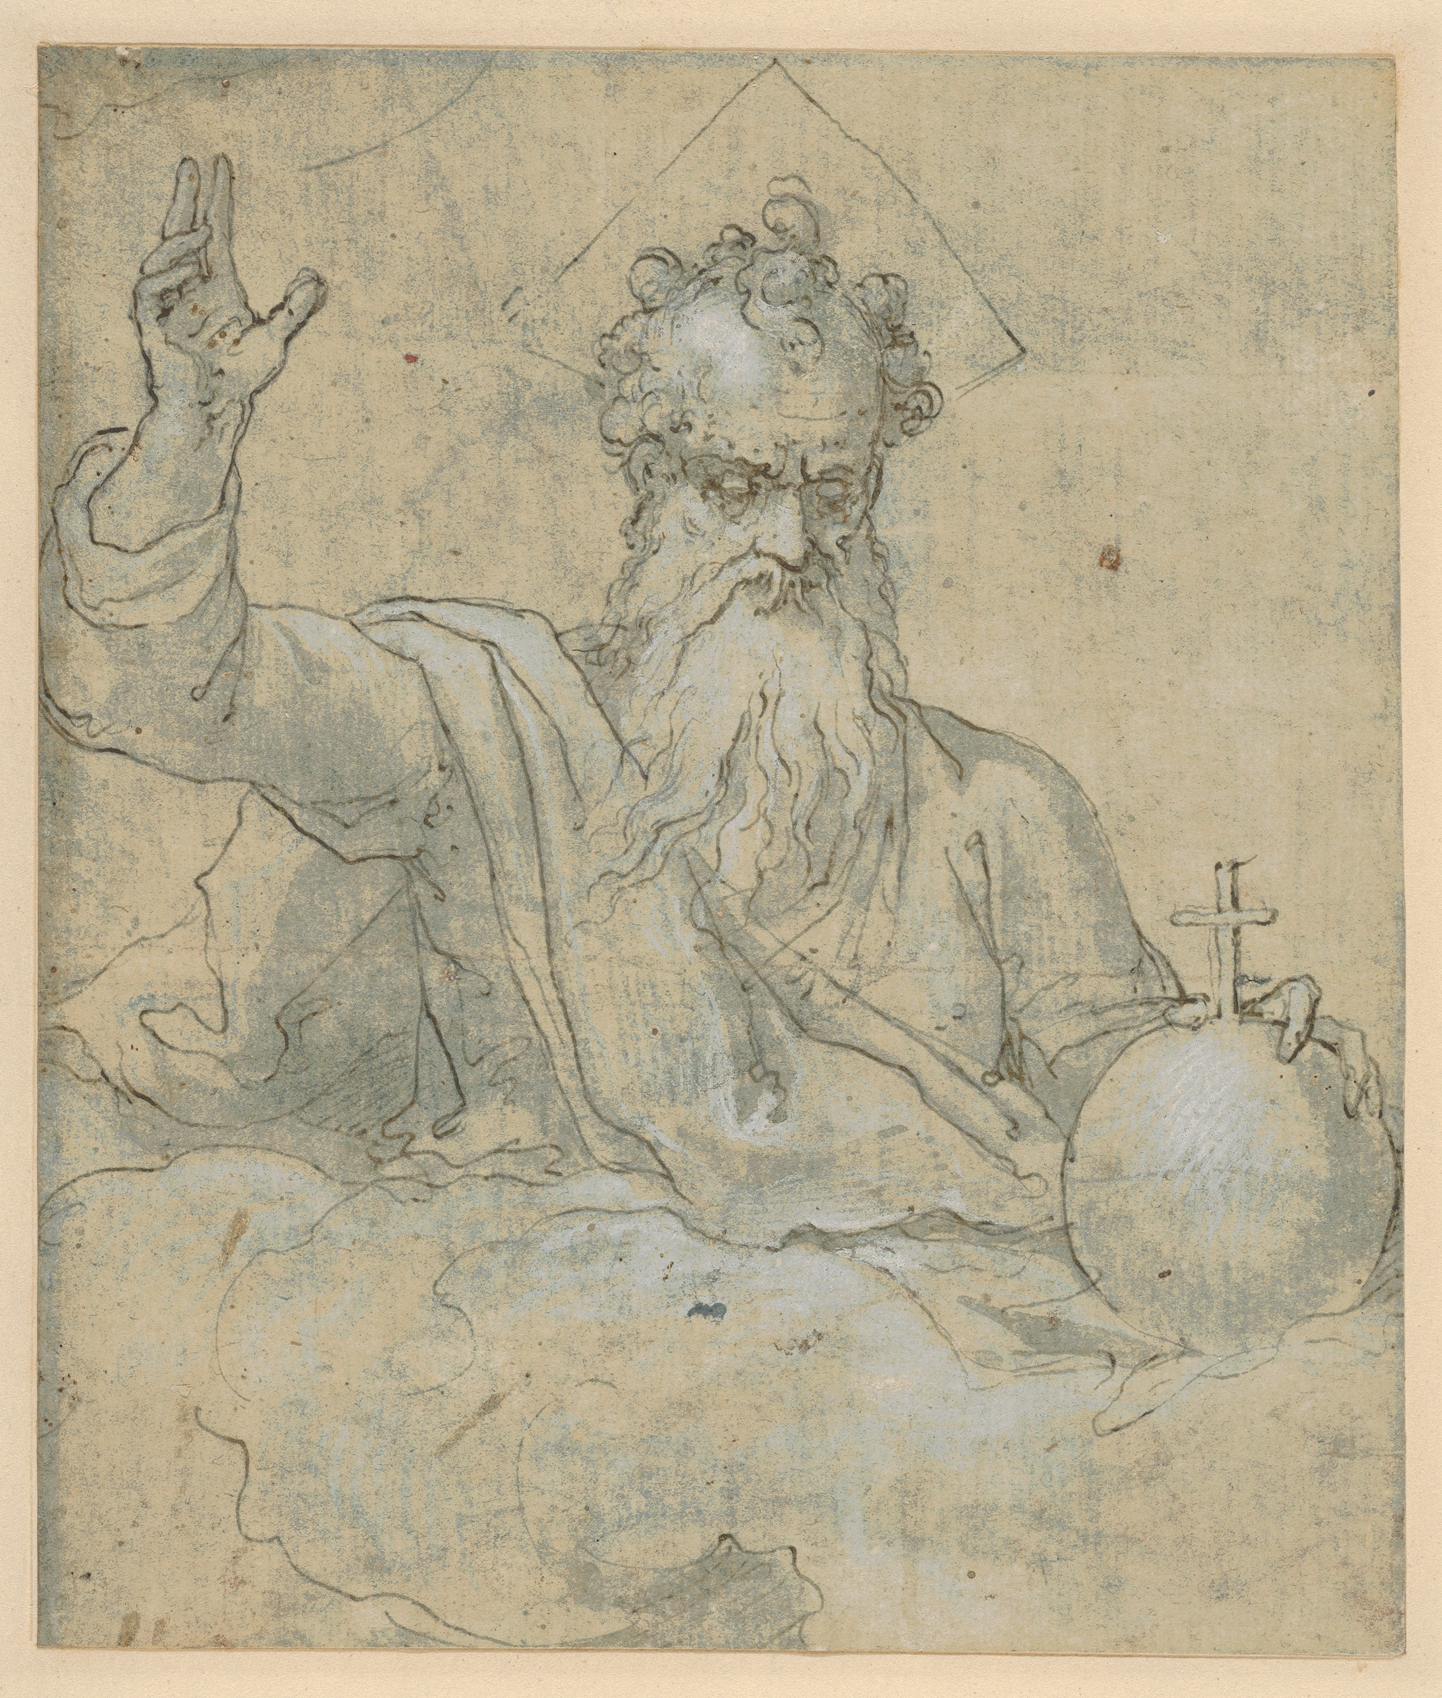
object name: drawing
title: God the Father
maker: federico zuccaro (zuccari)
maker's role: artist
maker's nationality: italian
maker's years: 1540-1609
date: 1570-1580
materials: chalk, gouache, ink, paper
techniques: brush, highlighting, pen, wash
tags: god the father